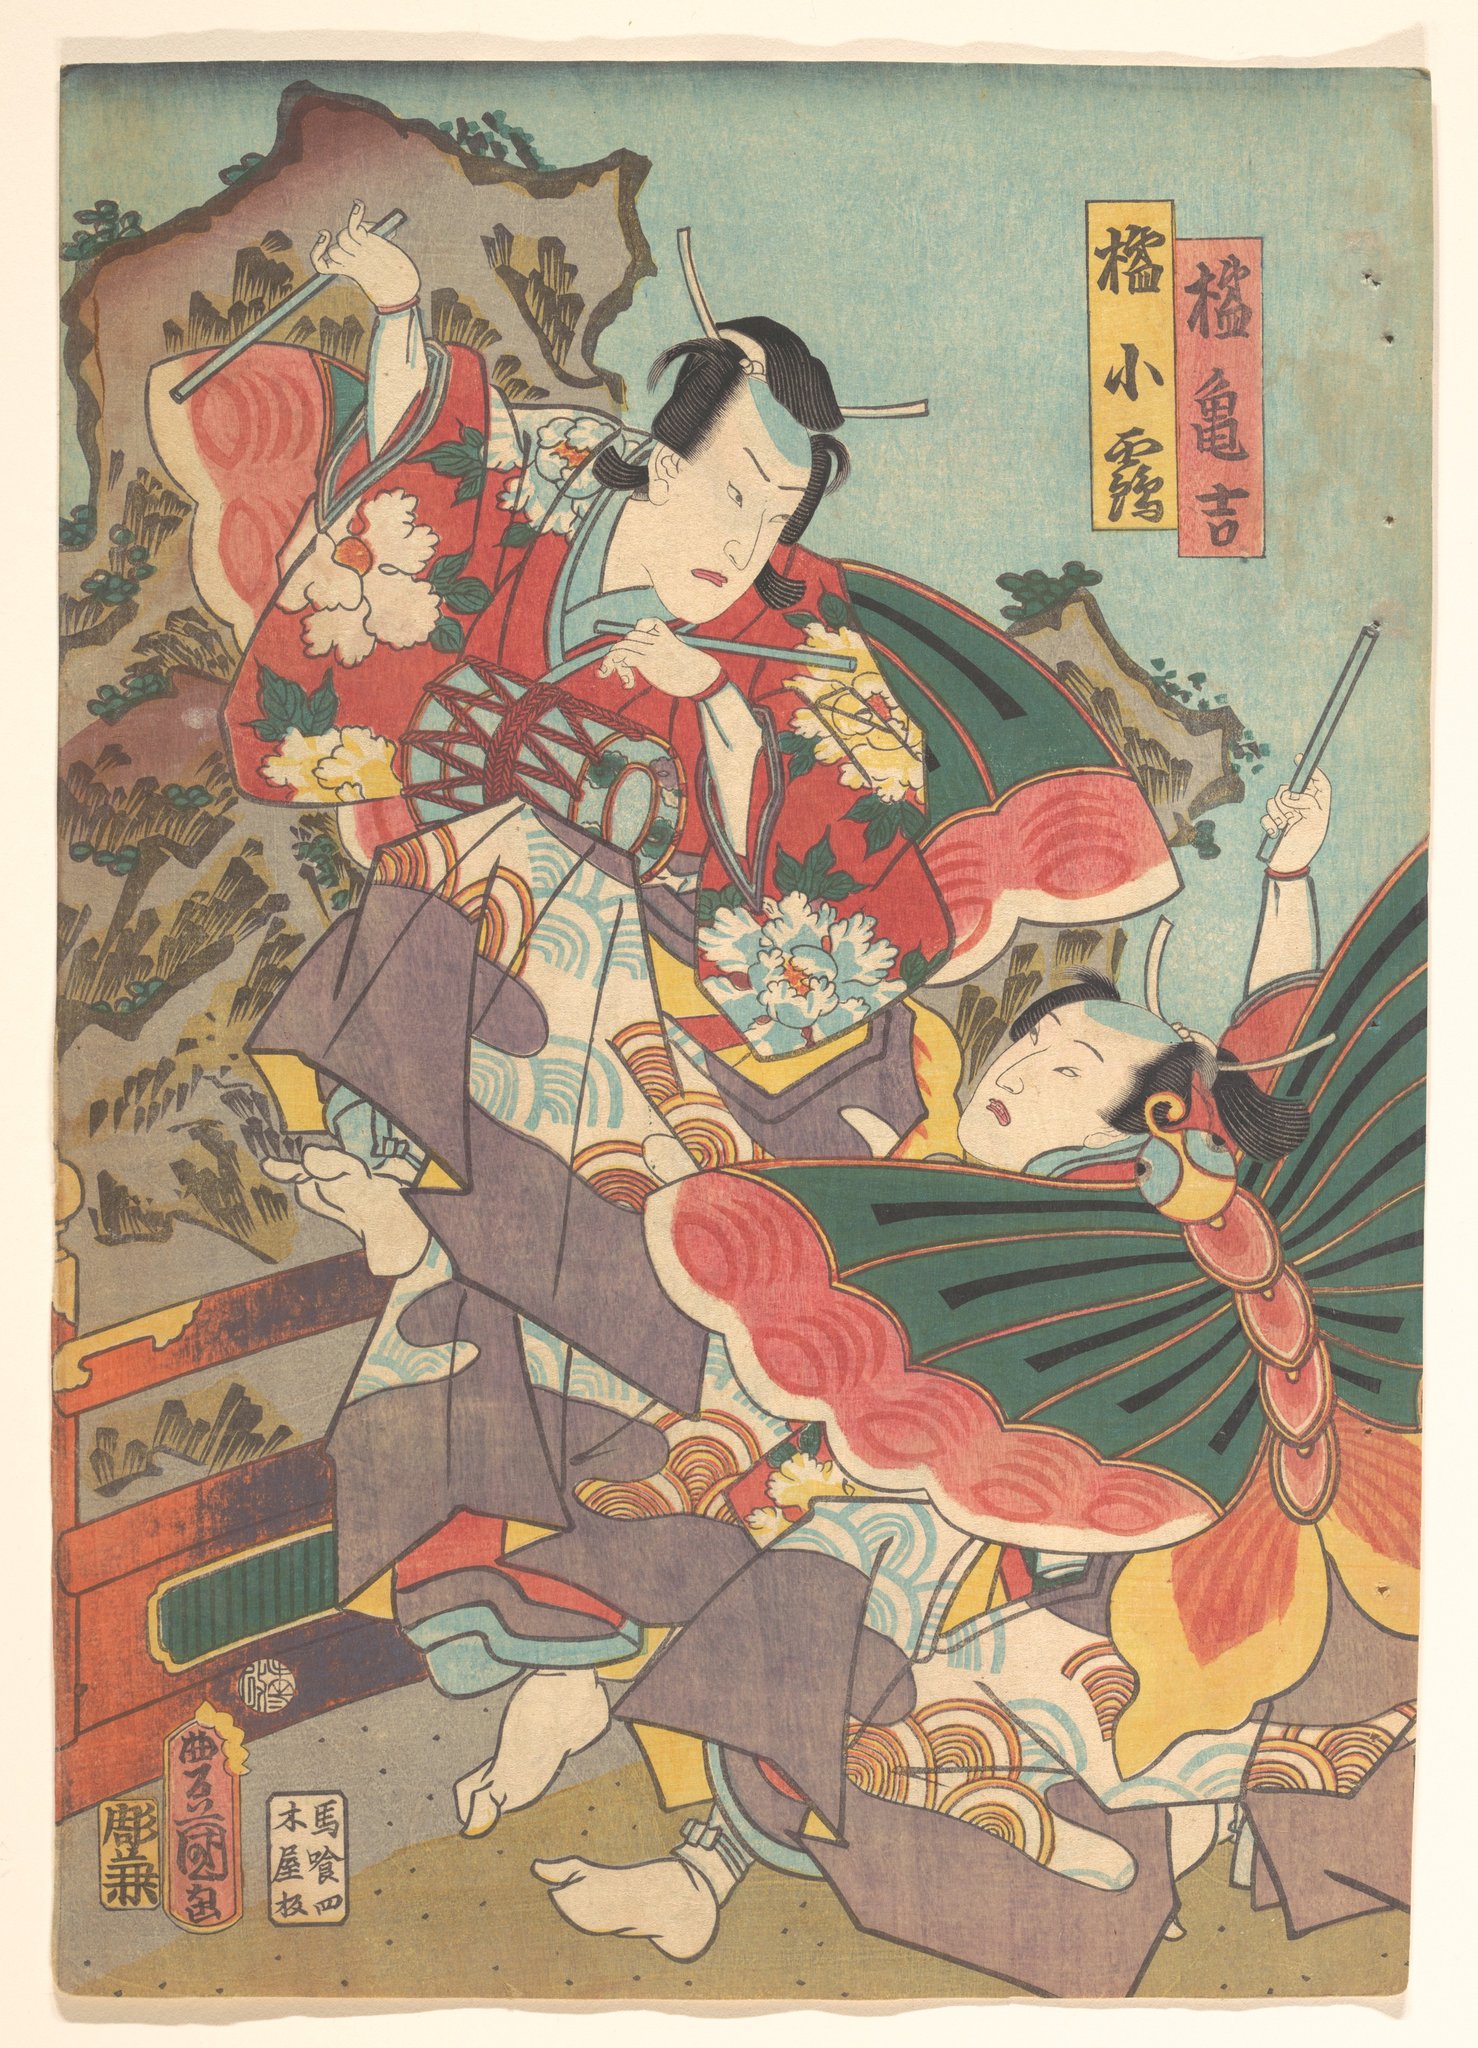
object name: print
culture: japanese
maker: utagawa kunisada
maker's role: artist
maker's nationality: japanese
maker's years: 1786-1864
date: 1801-1900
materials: ink, paper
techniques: woodblock print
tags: men